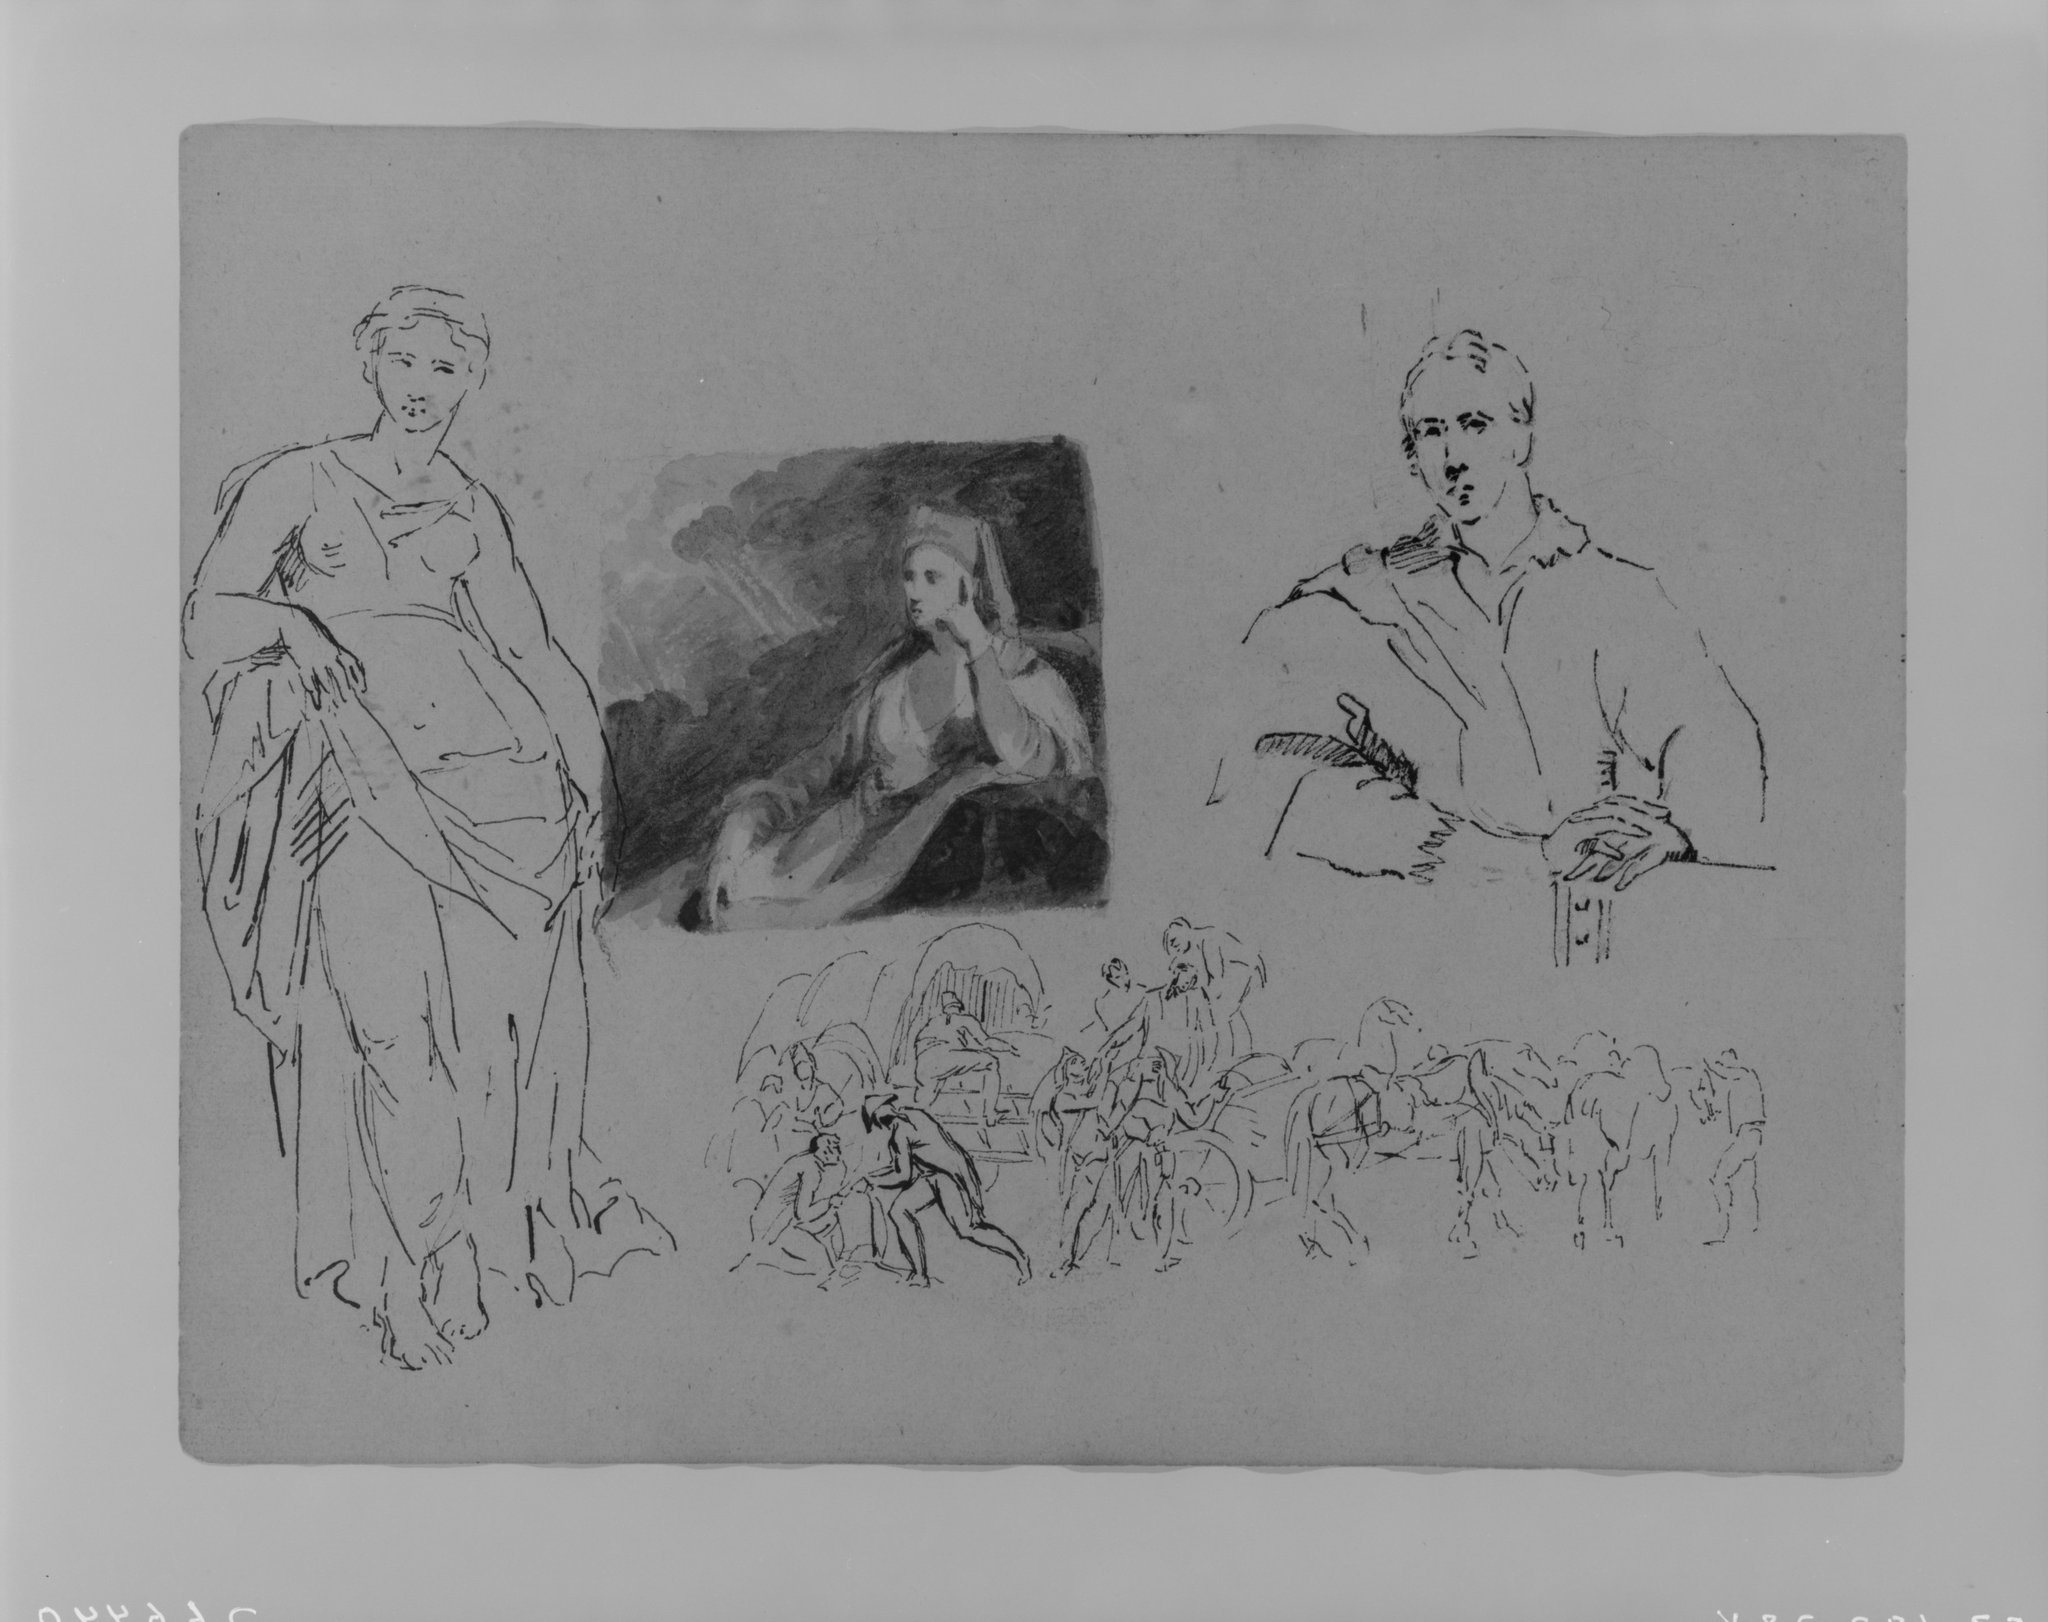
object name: drawing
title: Standing Draped Female Figure; Portrait of a Cleric; Half-length Portrait of a Man; Figures with Wagons and Horses (Napoleon Scene?) (from Sketchbook)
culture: american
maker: thomas sully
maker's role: artist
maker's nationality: american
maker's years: 1783-1872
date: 1810-1820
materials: ink, paper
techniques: wash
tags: men,portraits,women,horses